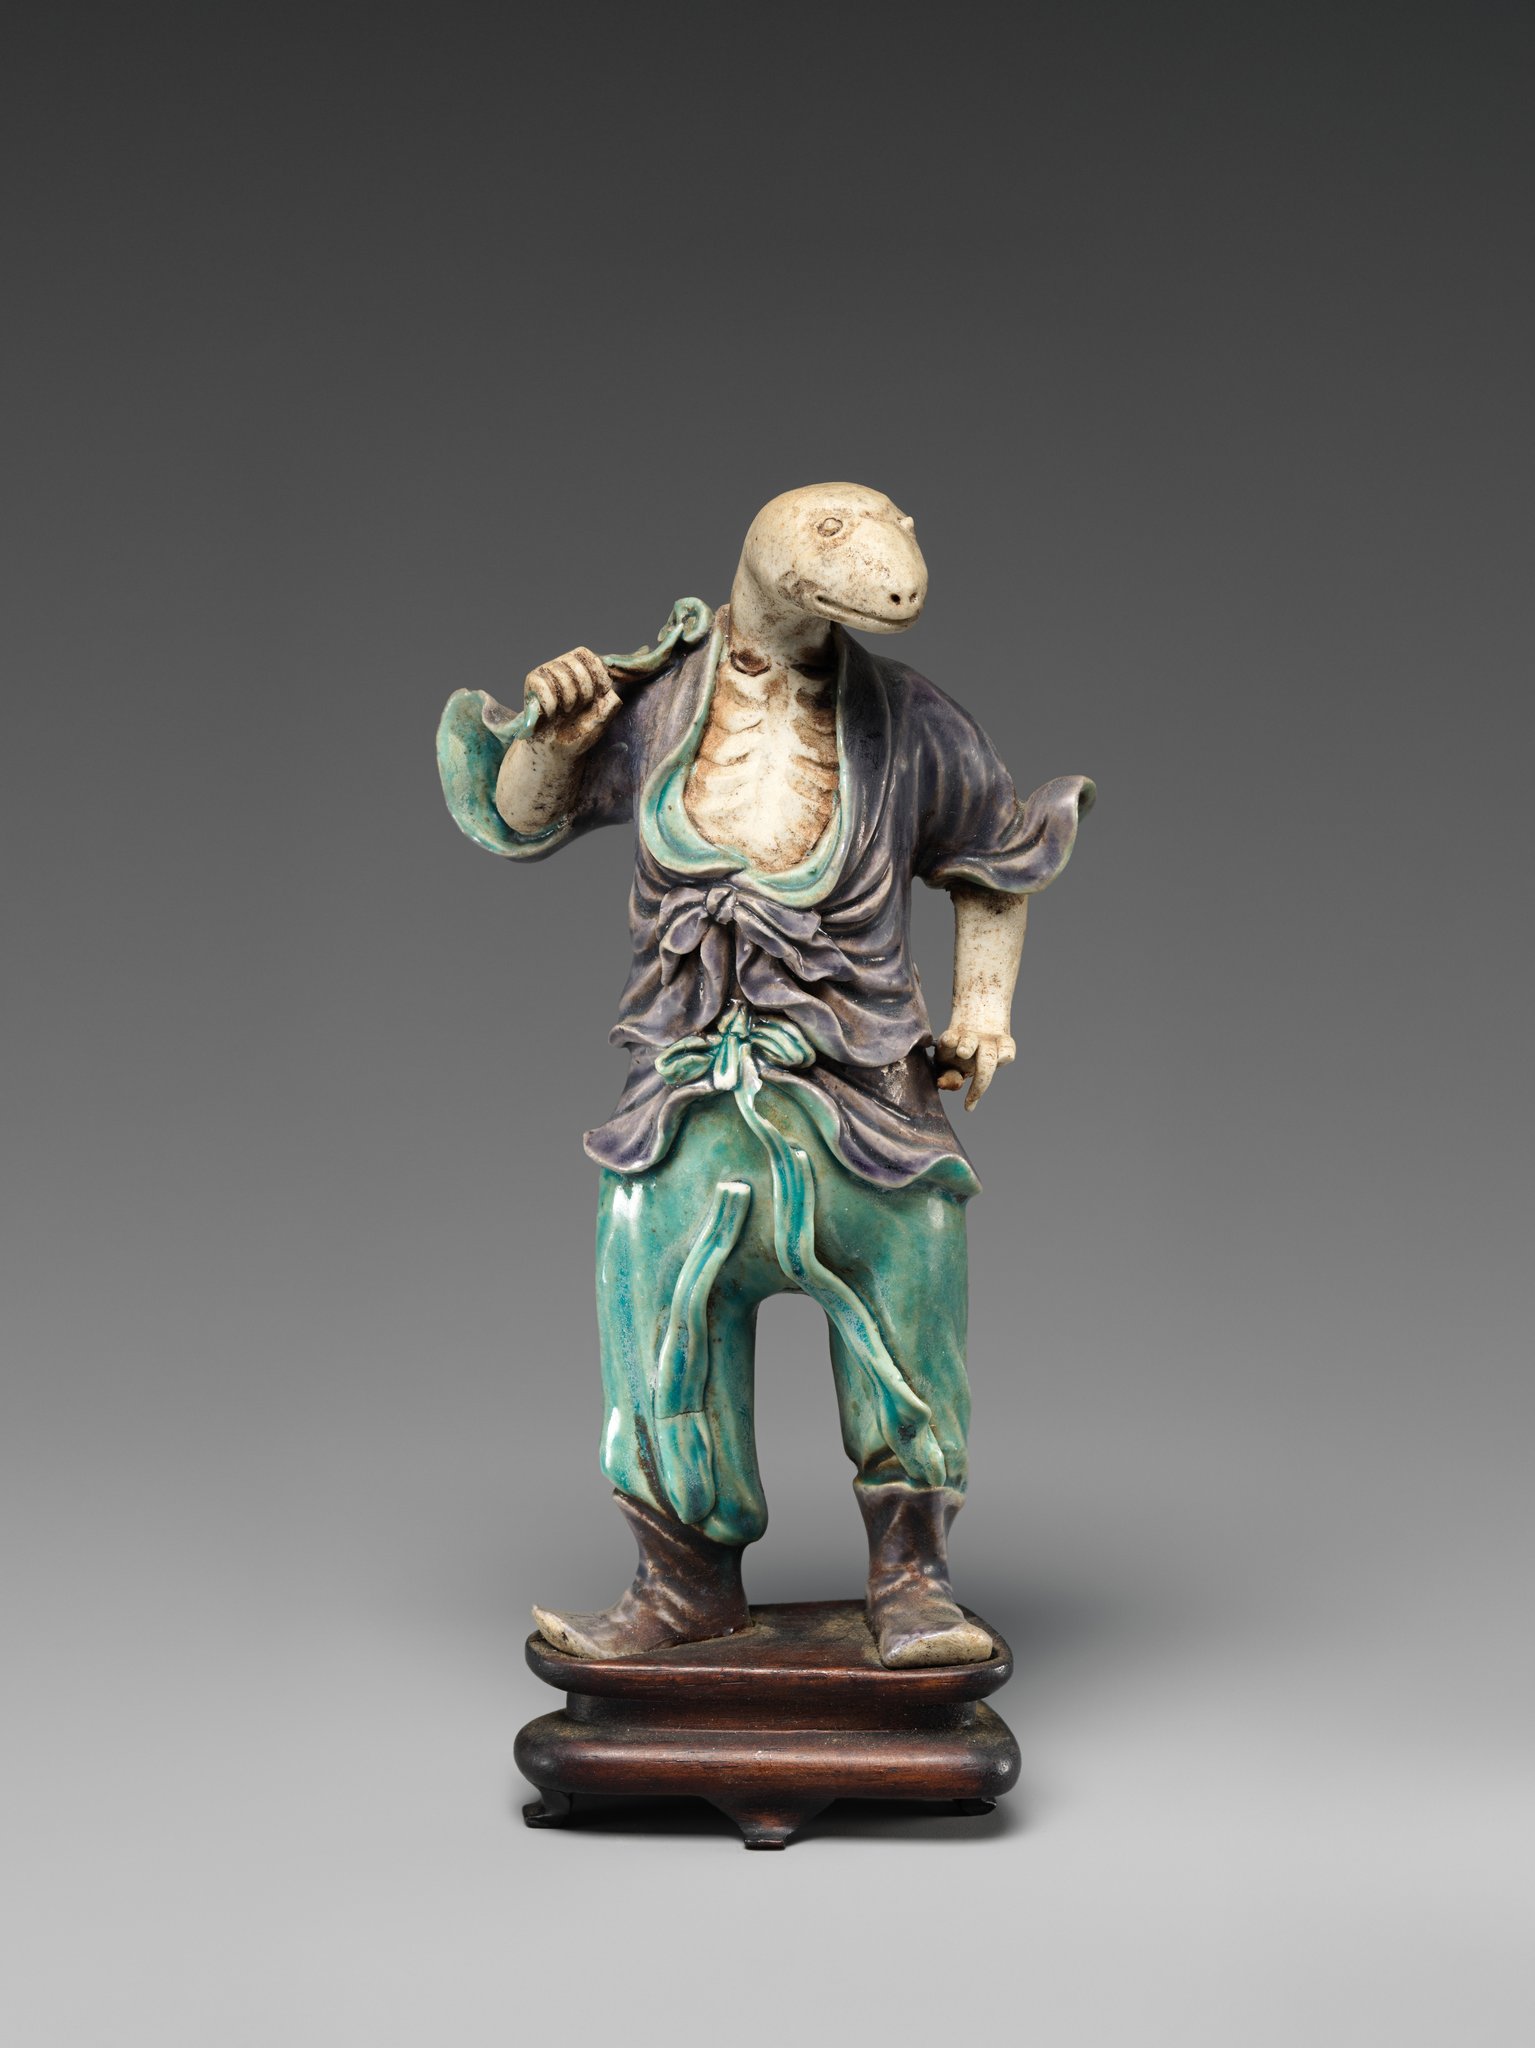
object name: figure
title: Zodiac Figure: Snake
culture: chinese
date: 1601-1700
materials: glaze, porcelain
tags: zodiac